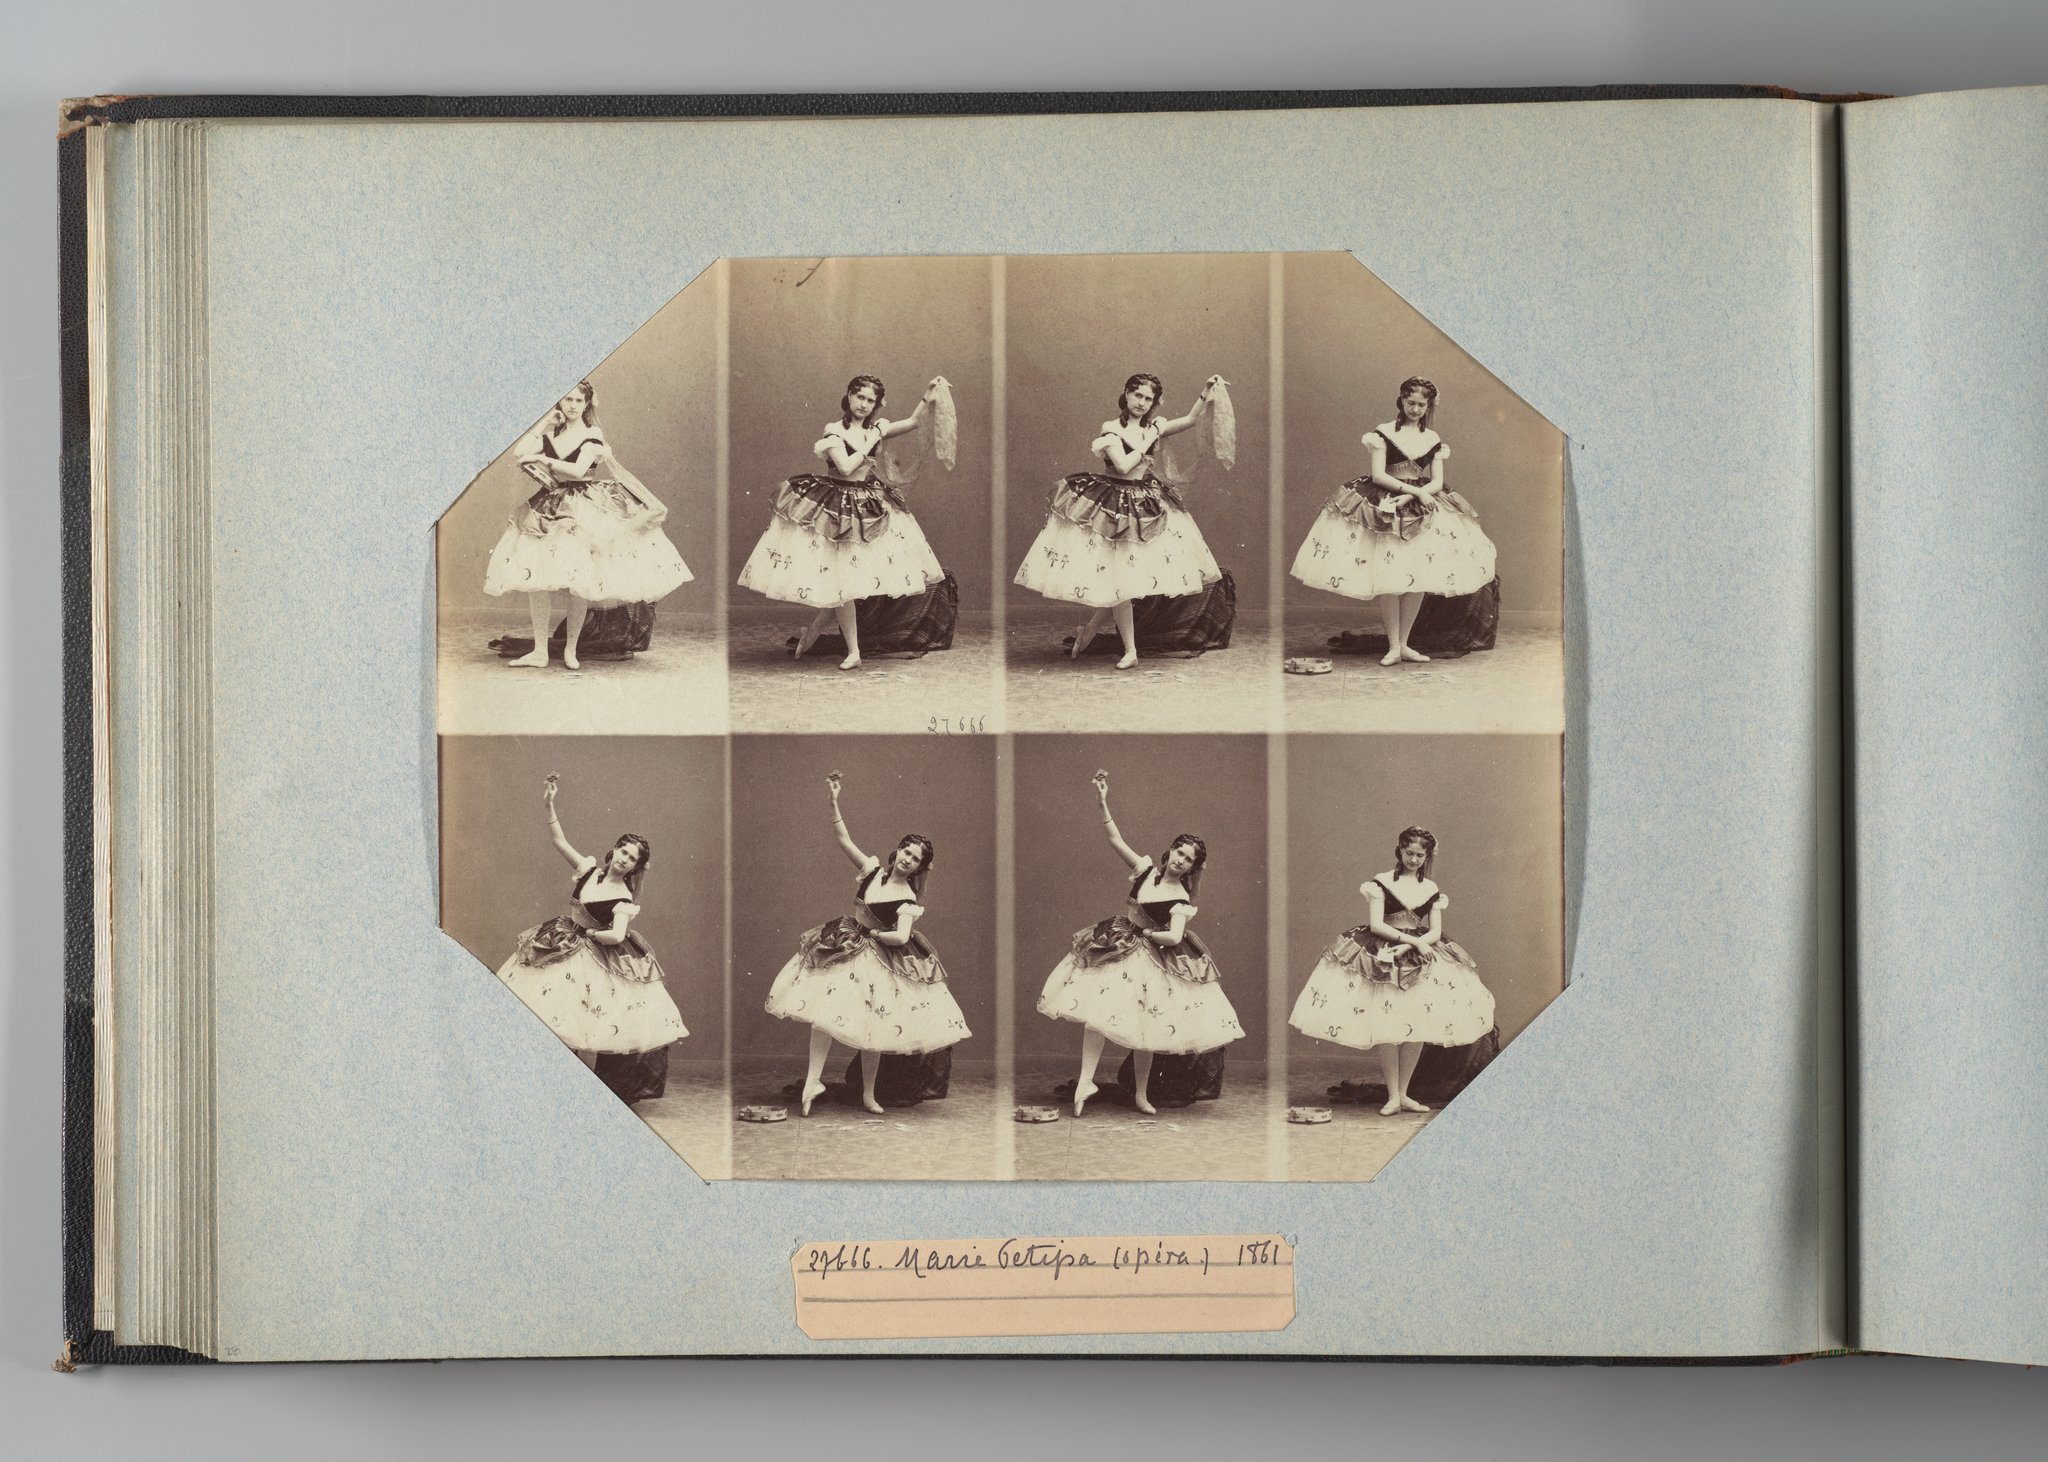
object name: photograph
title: Marie Petipa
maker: andré-adolphe-eugène disdéri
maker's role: artist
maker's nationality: french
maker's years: 1819-1889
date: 1861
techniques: albumen silver print, glass negative